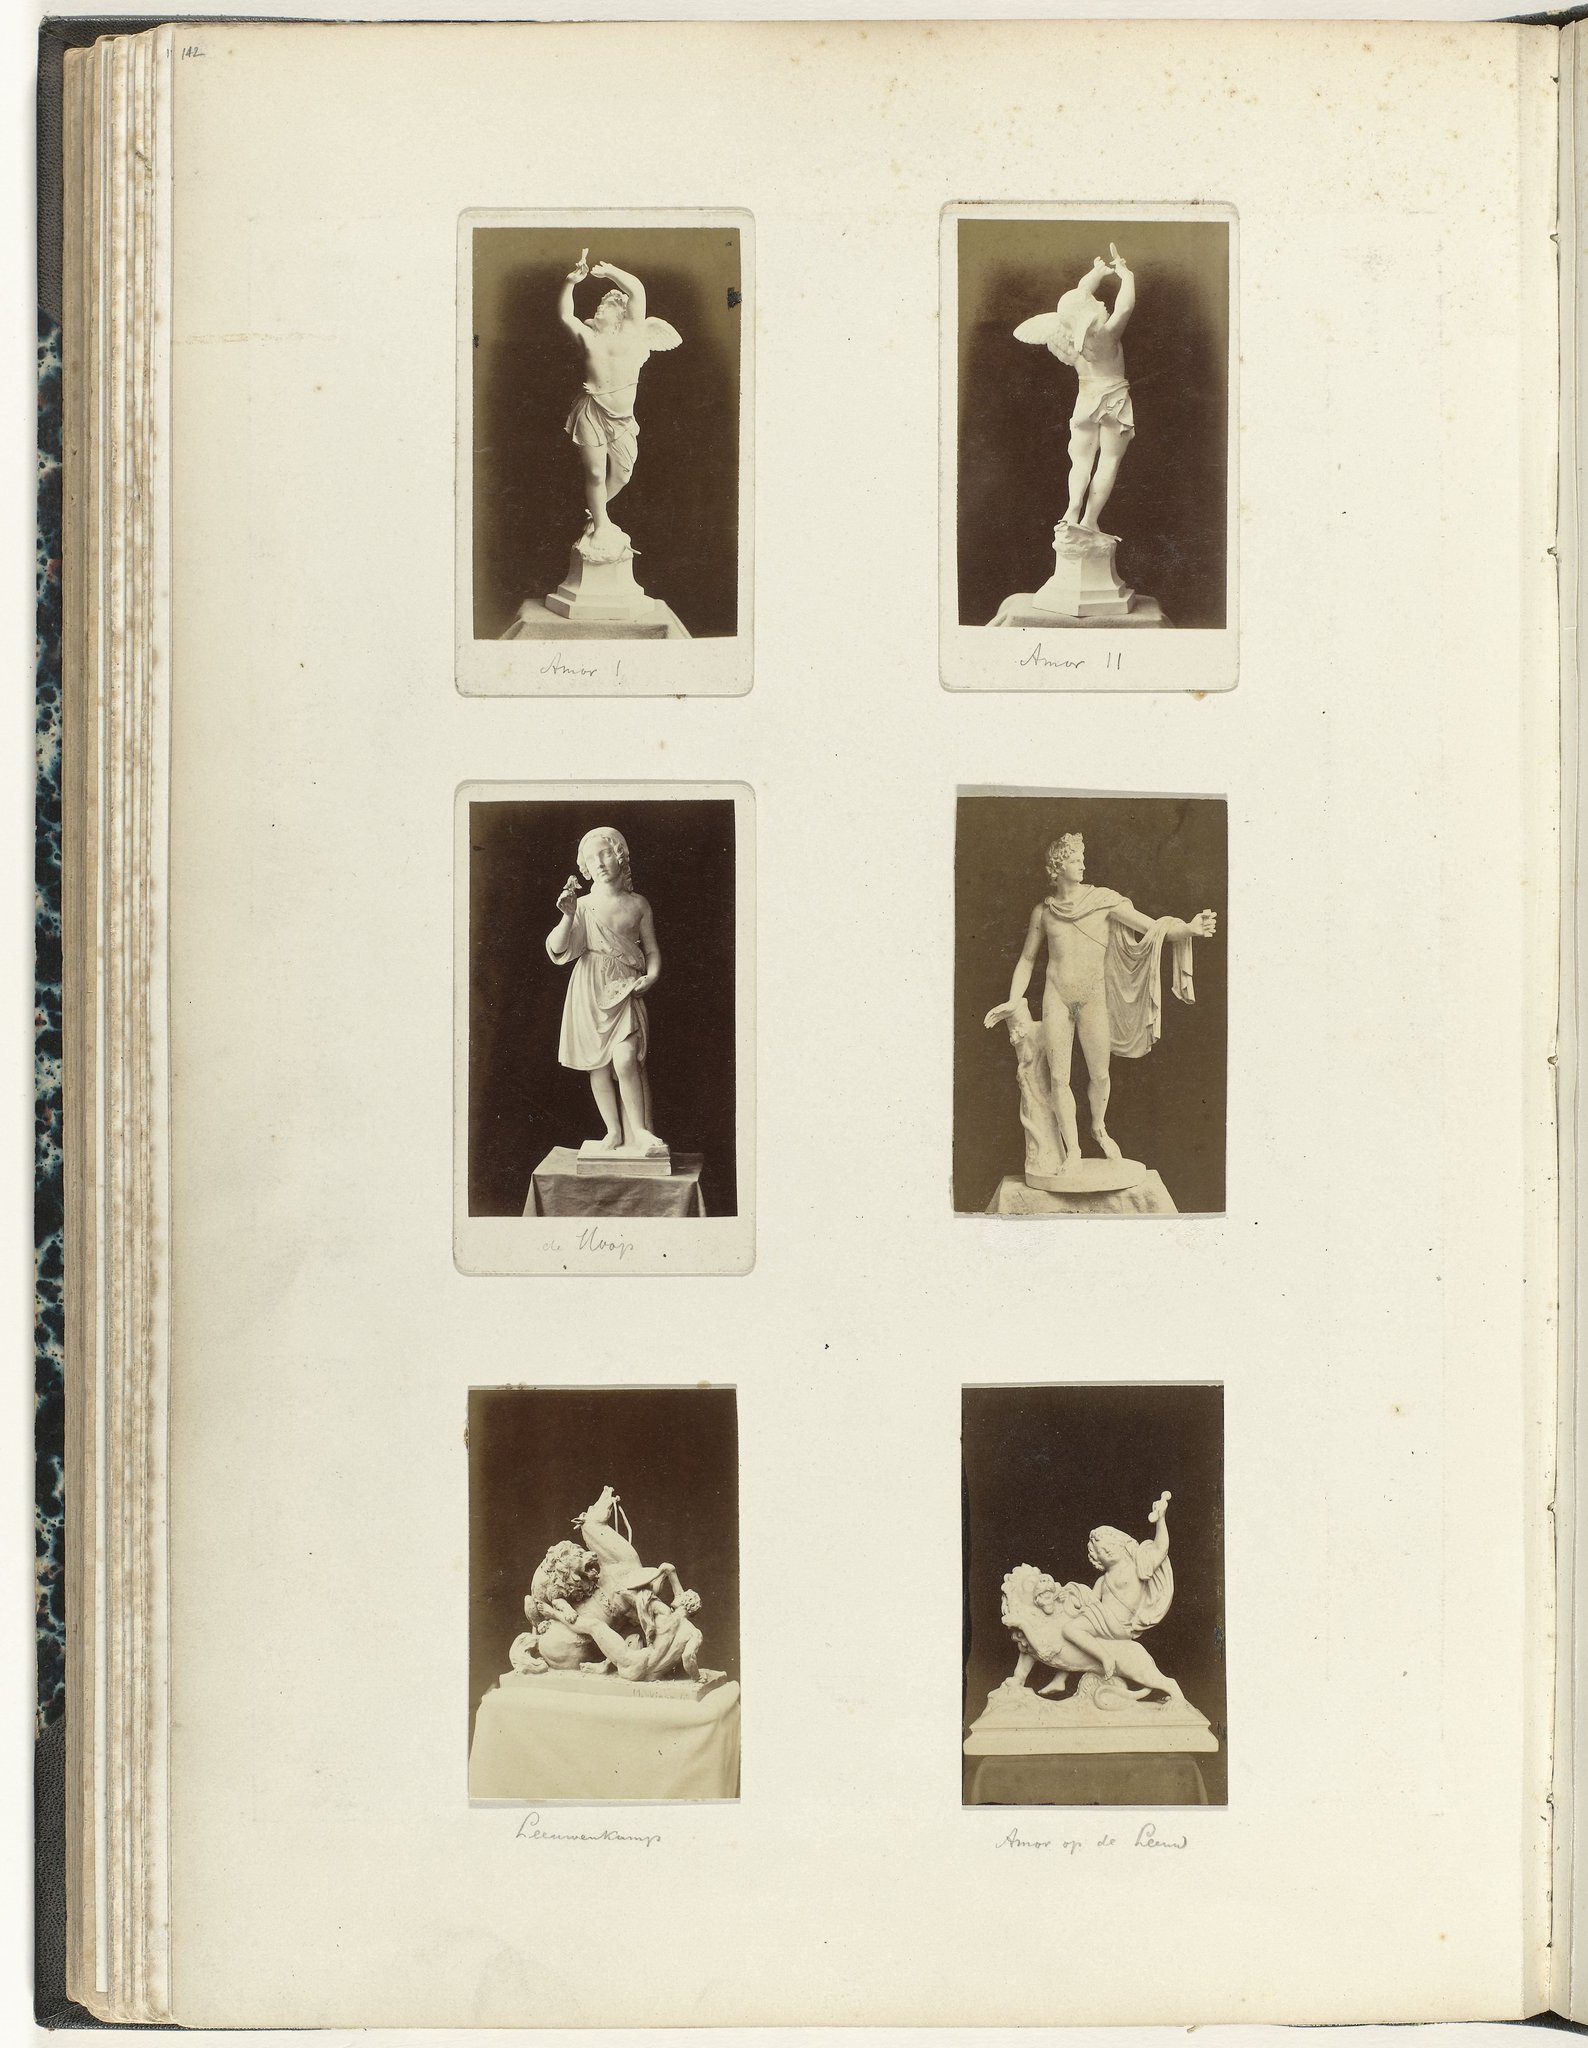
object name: photograph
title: Vijf cartes-de-visite met beelden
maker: Anonymous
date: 1866-1900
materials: cardboard, paper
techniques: albumen print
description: Twee beelden van een staande Amor, een beeld van Hoop, een beeld van een leeuw op de rug van een paard waarnaast een gevallen man ligt en een beeld met Amor op de rug van een leeuw. Onderaan de cartes-de-visite staat met potlood geschreven wat er afgebeeld is, onder de gevallen man staat met potlood: M. Wieco (?).